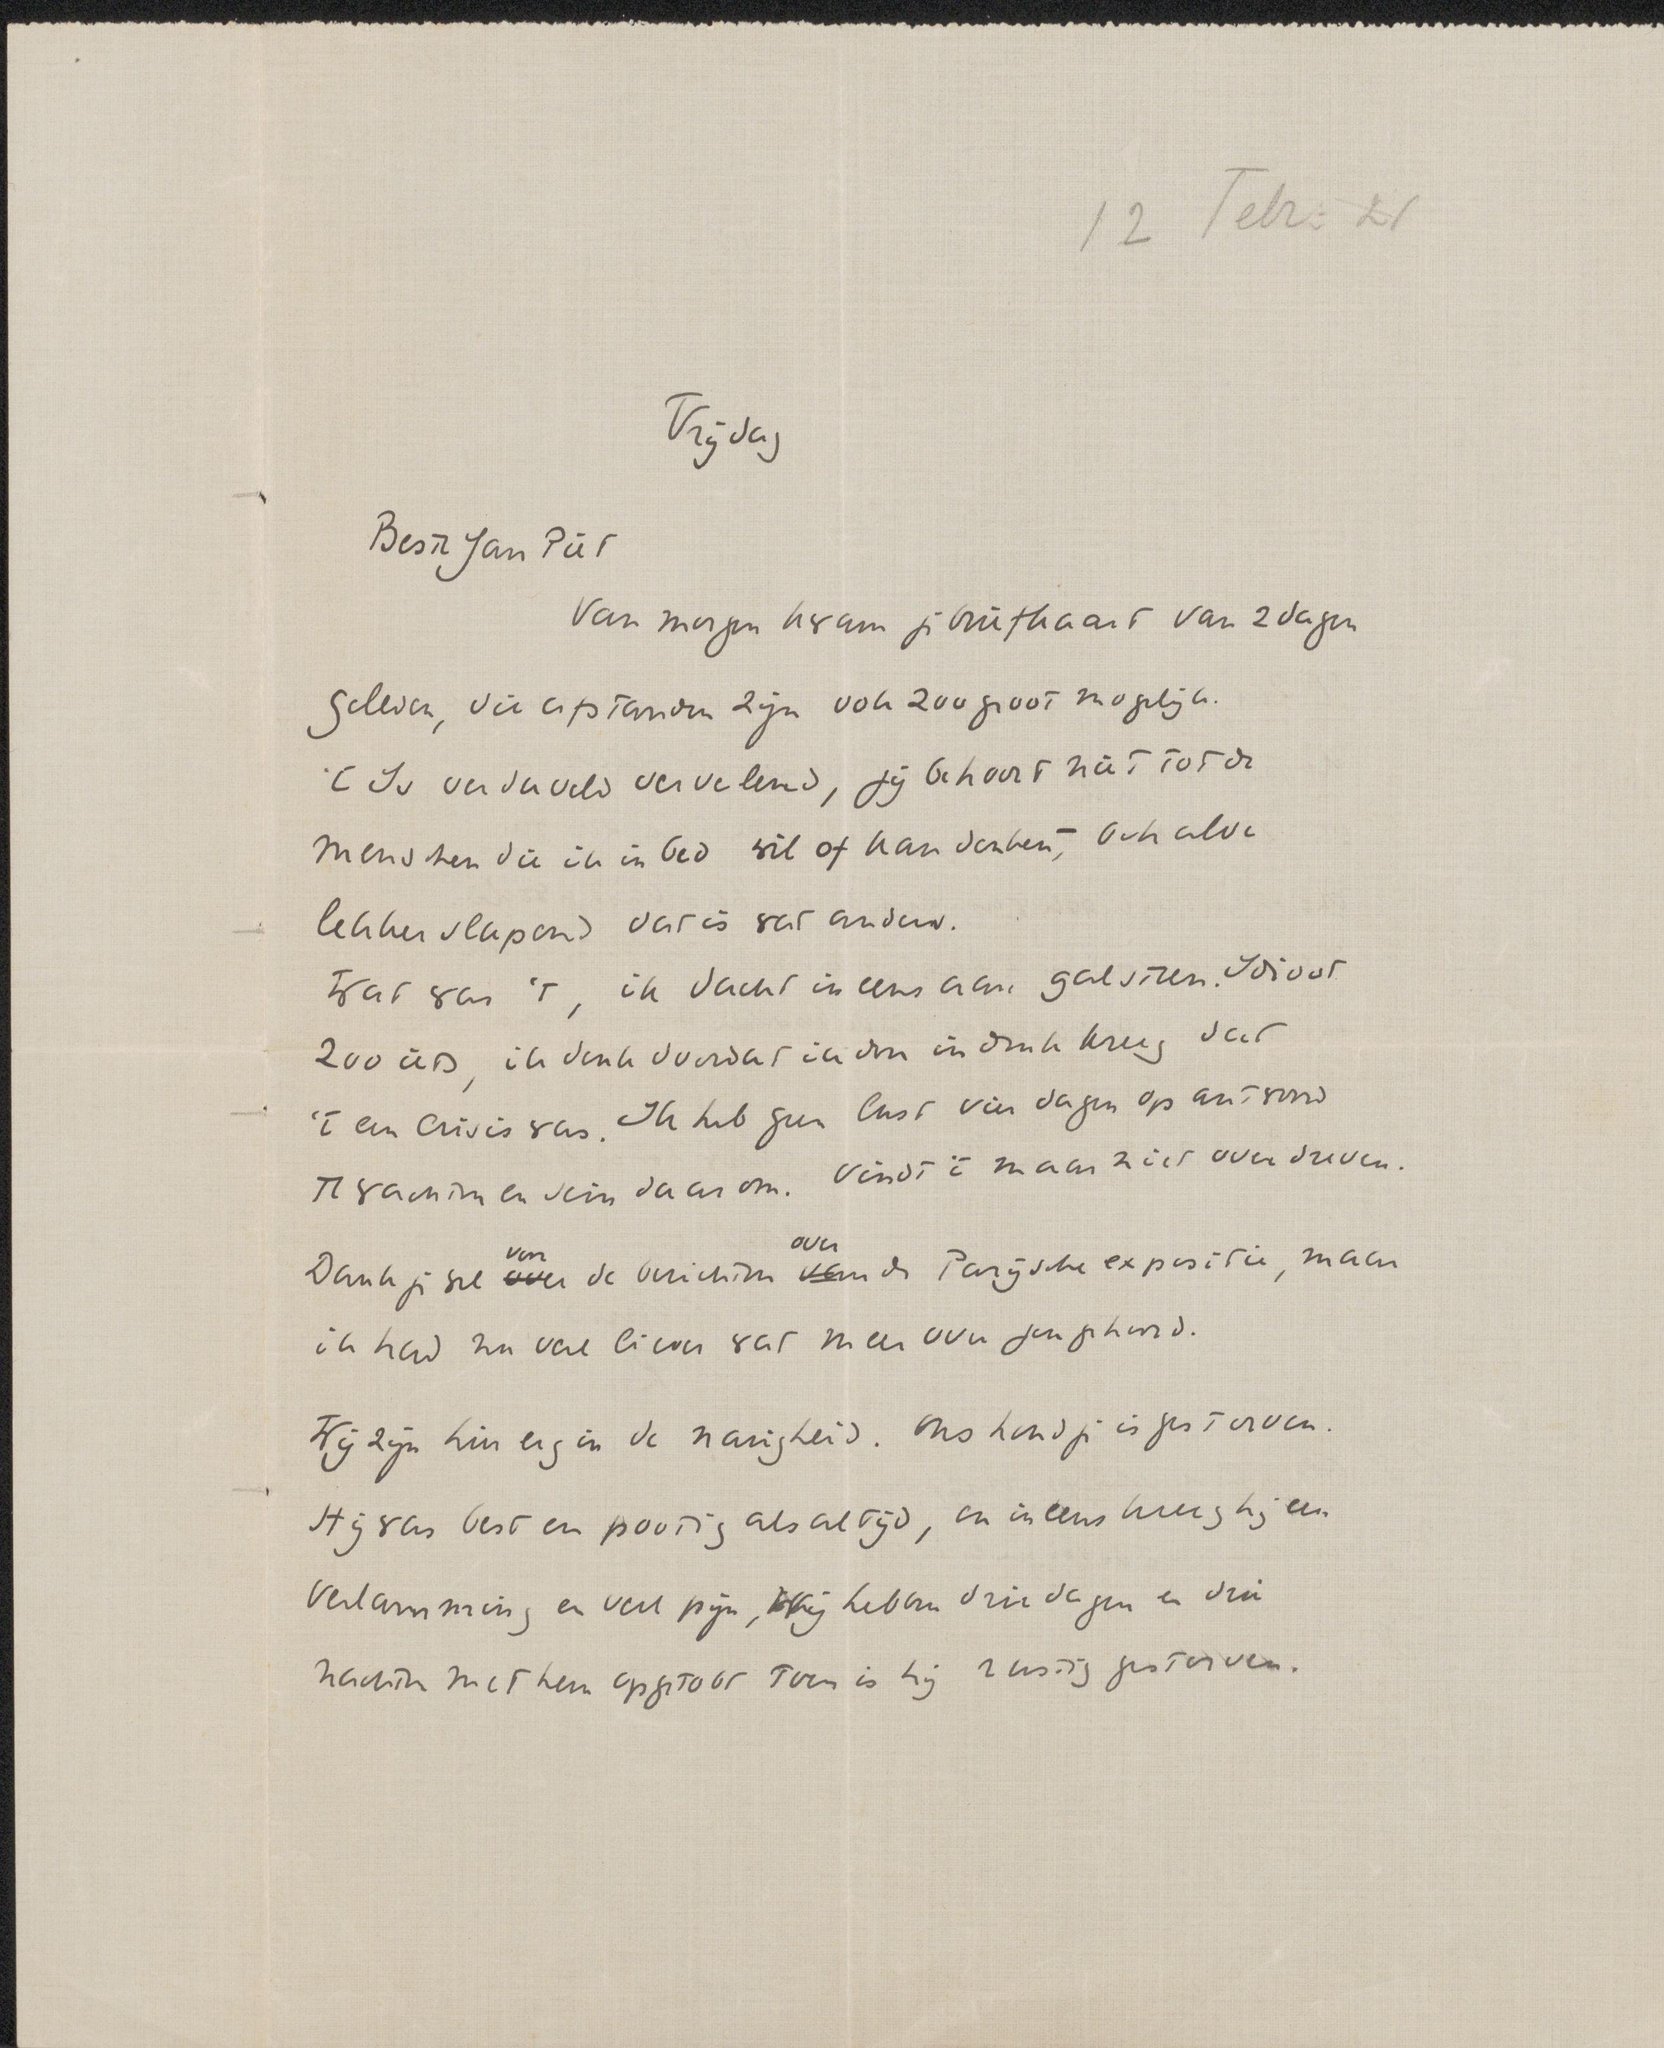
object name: letter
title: Brief aan Jan Veth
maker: richard nicolaüs roland holst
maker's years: 1868-1938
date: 1878-1925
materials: ink, paper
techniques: pen, writing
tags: painter, print maker, draughtsman, designer, jan veth, passions, emotions, affections, exhibition ~ art, paris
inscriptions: collector's mark: ‘RPK’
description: Brief gedateerd 12 Febr: 21 in latere hand.